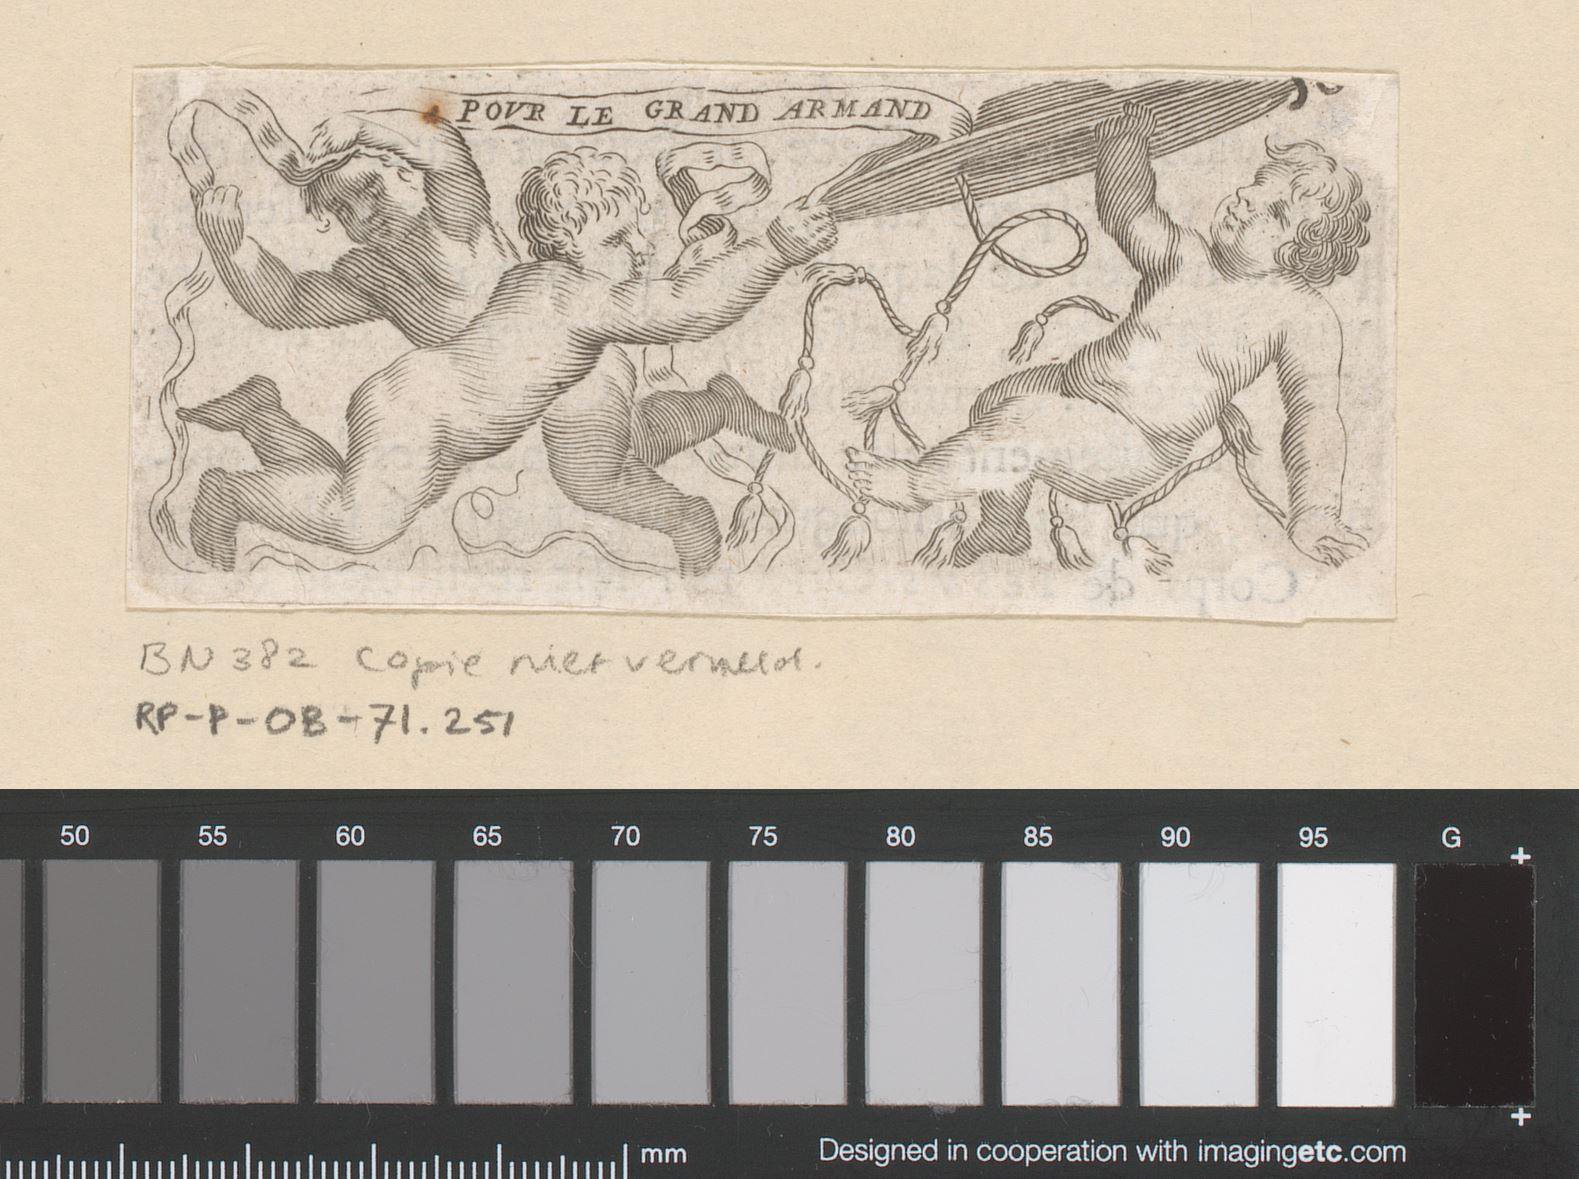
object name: print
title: Drie putti met kardinaalshoed en band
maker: Anonymous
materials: paper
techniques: engraving, letterpress printing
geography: france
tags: insignia of cardinal, e.g. hat, mantle, cupids: 'amores', 'amoretti', 'putti'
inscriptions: collector's mark: Lugt 240